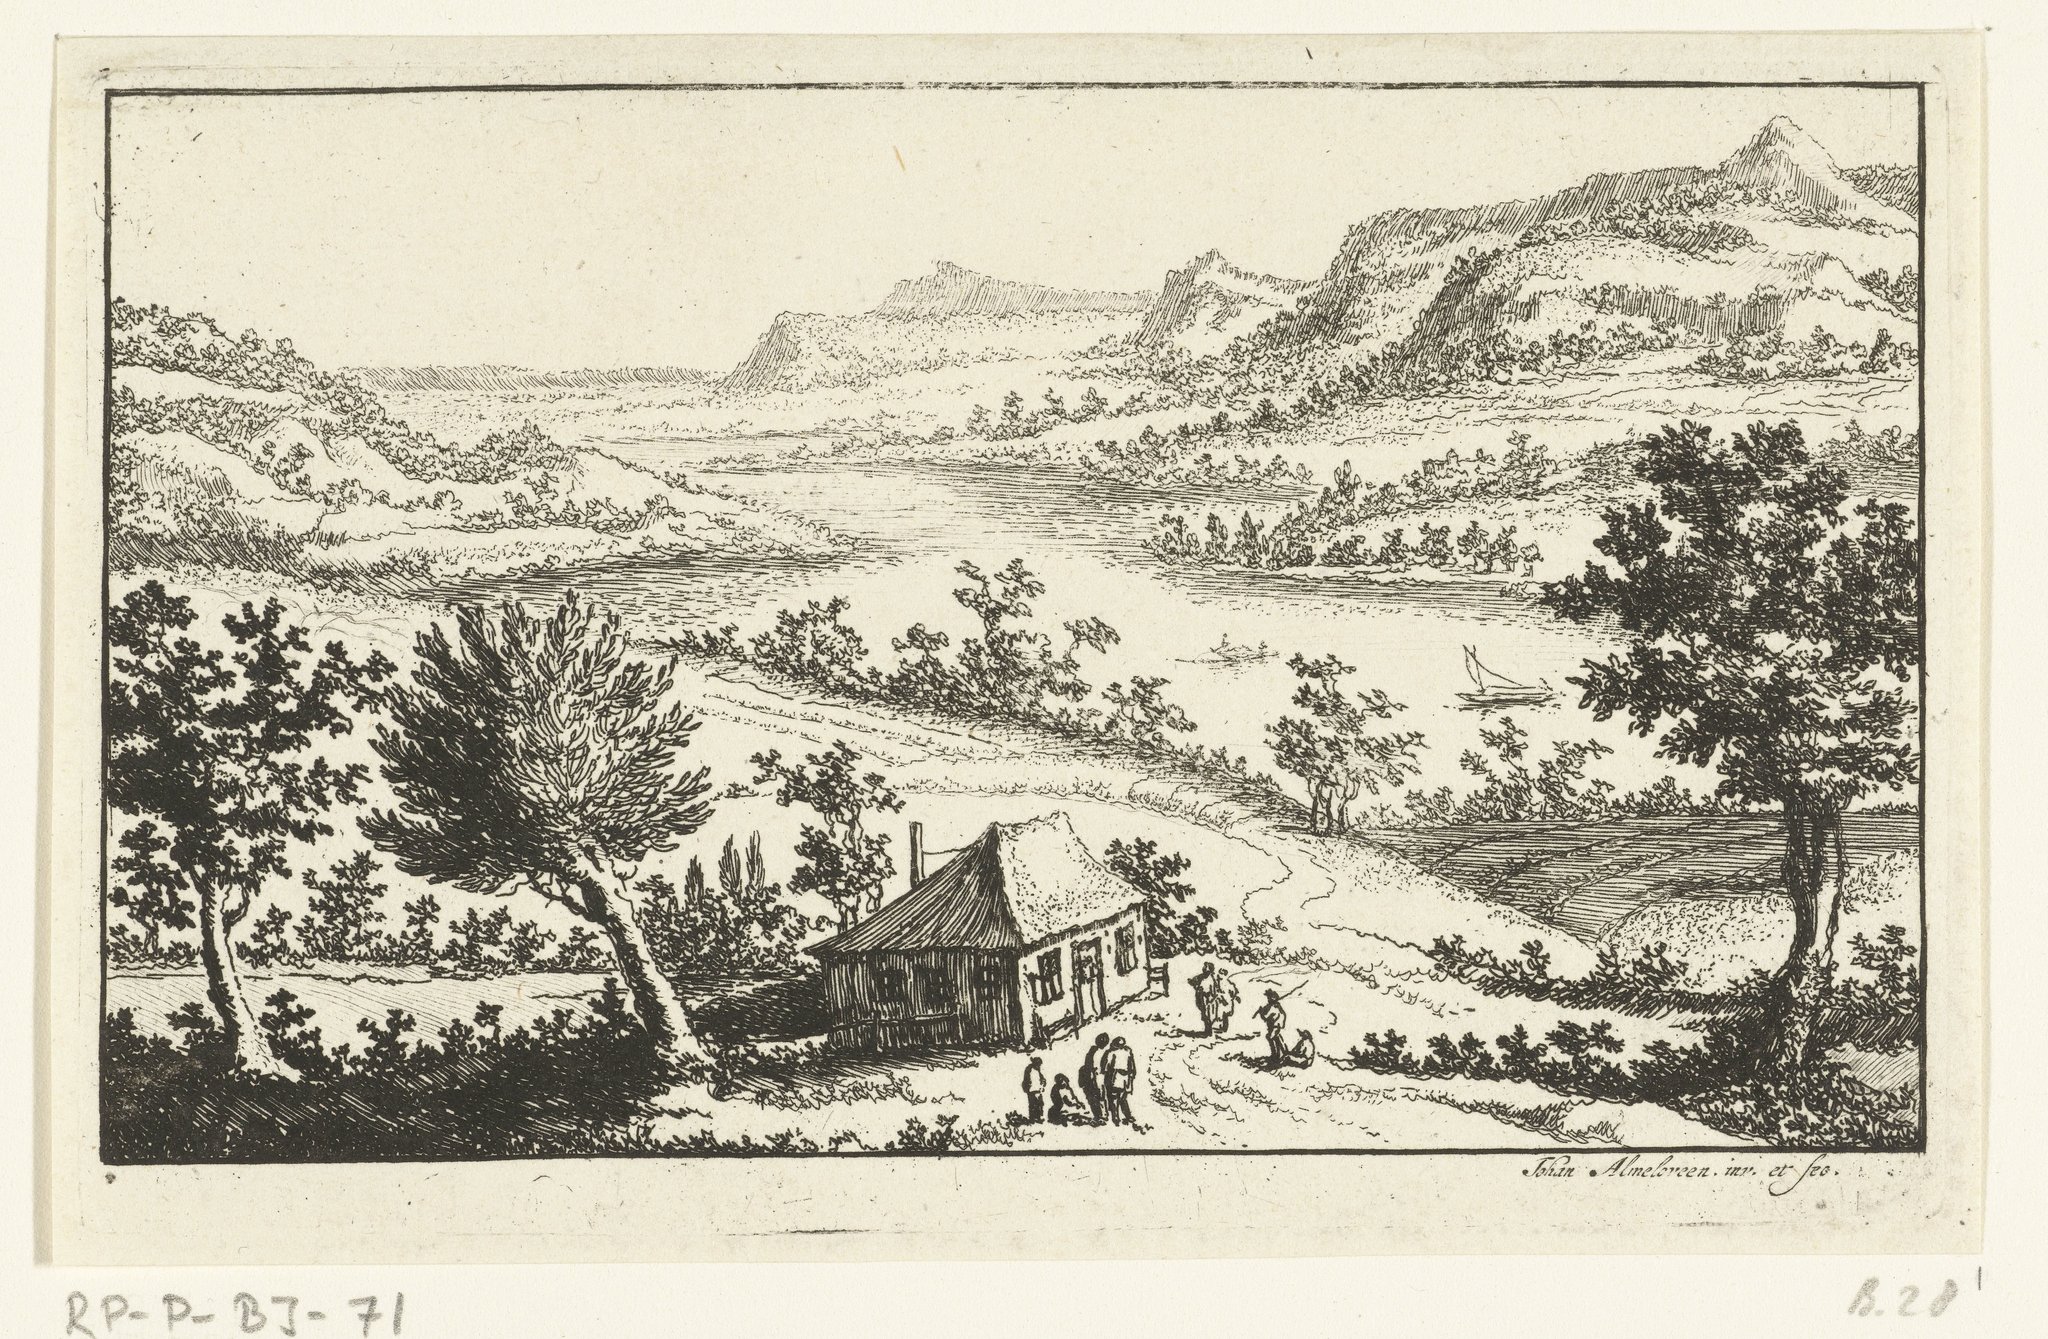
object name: print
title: Huis aan de oever van een rivier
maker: jan van almeloveen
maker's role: draughtsman, print maker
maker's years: 1652-1683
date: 1662-1683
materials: paper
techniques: etching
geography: netherlands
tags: river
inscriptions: collector's mark: Lugt 240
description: Prent uit een serie van zes rivierlandschappen. De rivier is mogelijk de Oder.